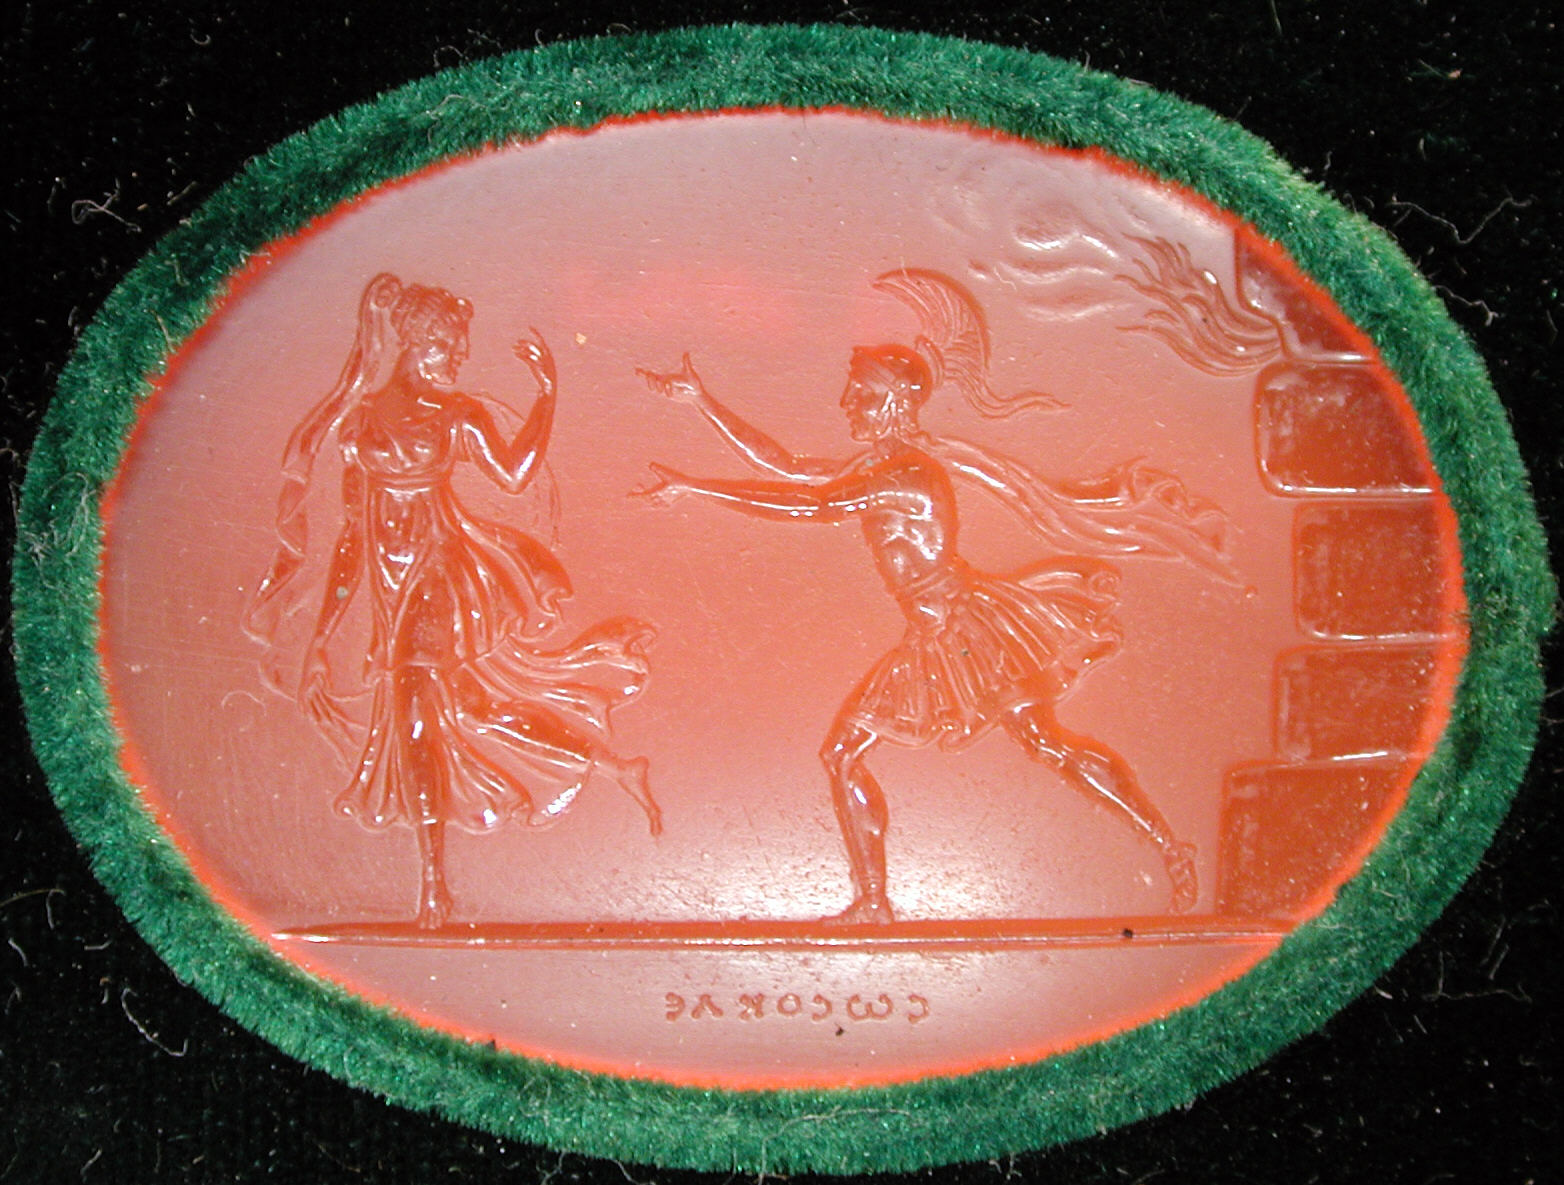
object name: intaglio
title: The ghost of Creusa disappearing from Aeneas near the burning wall of Troy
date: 1801-1833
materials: gemstone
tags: women,aeneas